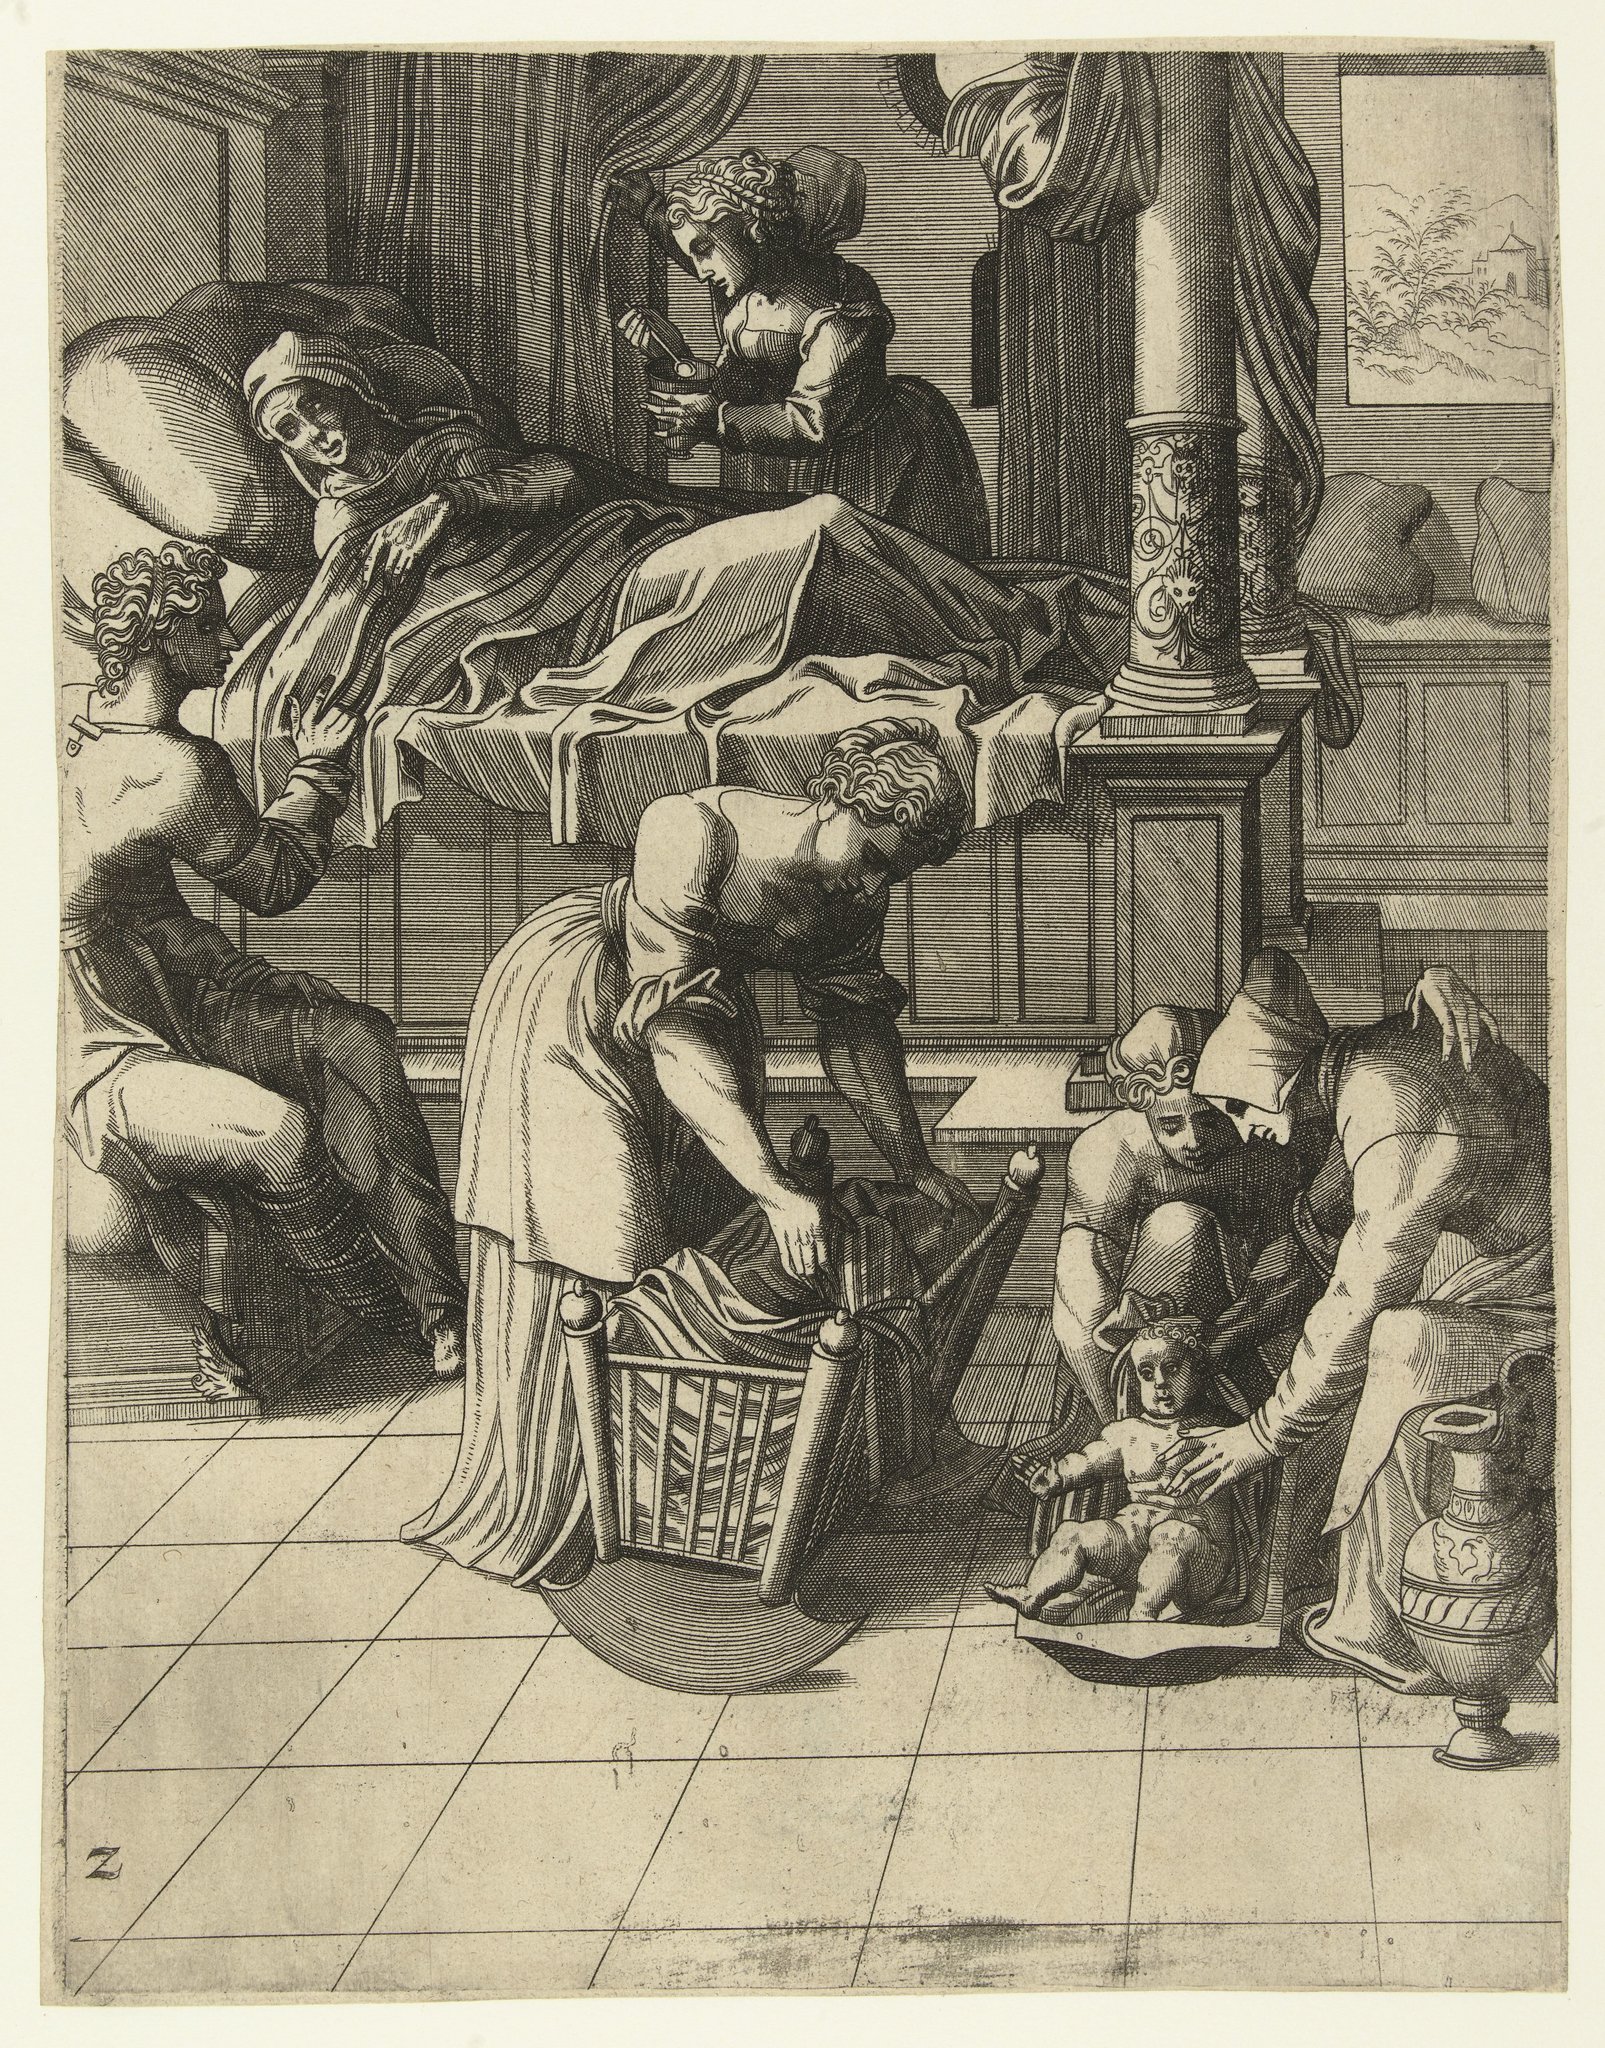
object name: print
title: Geboorte van Johannes de Doper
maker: hans liefrinck (i)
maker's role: print maker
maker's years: 1518-1573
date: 1553-1558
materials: paper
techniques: etching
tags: birth of john the baptist, sometimes mary present, story of john the baptist (matthew 3; mark 1:4-11; luke 3:1-22; john 1:19-34)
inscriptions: collector's mark: Lugt 2228a, collector's mark: Lugt 2760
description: Slaapkamer met drie vrouwen die pasgeboren baby Johannes wassen en wieg klaarmaken. Elisabeth in bed.